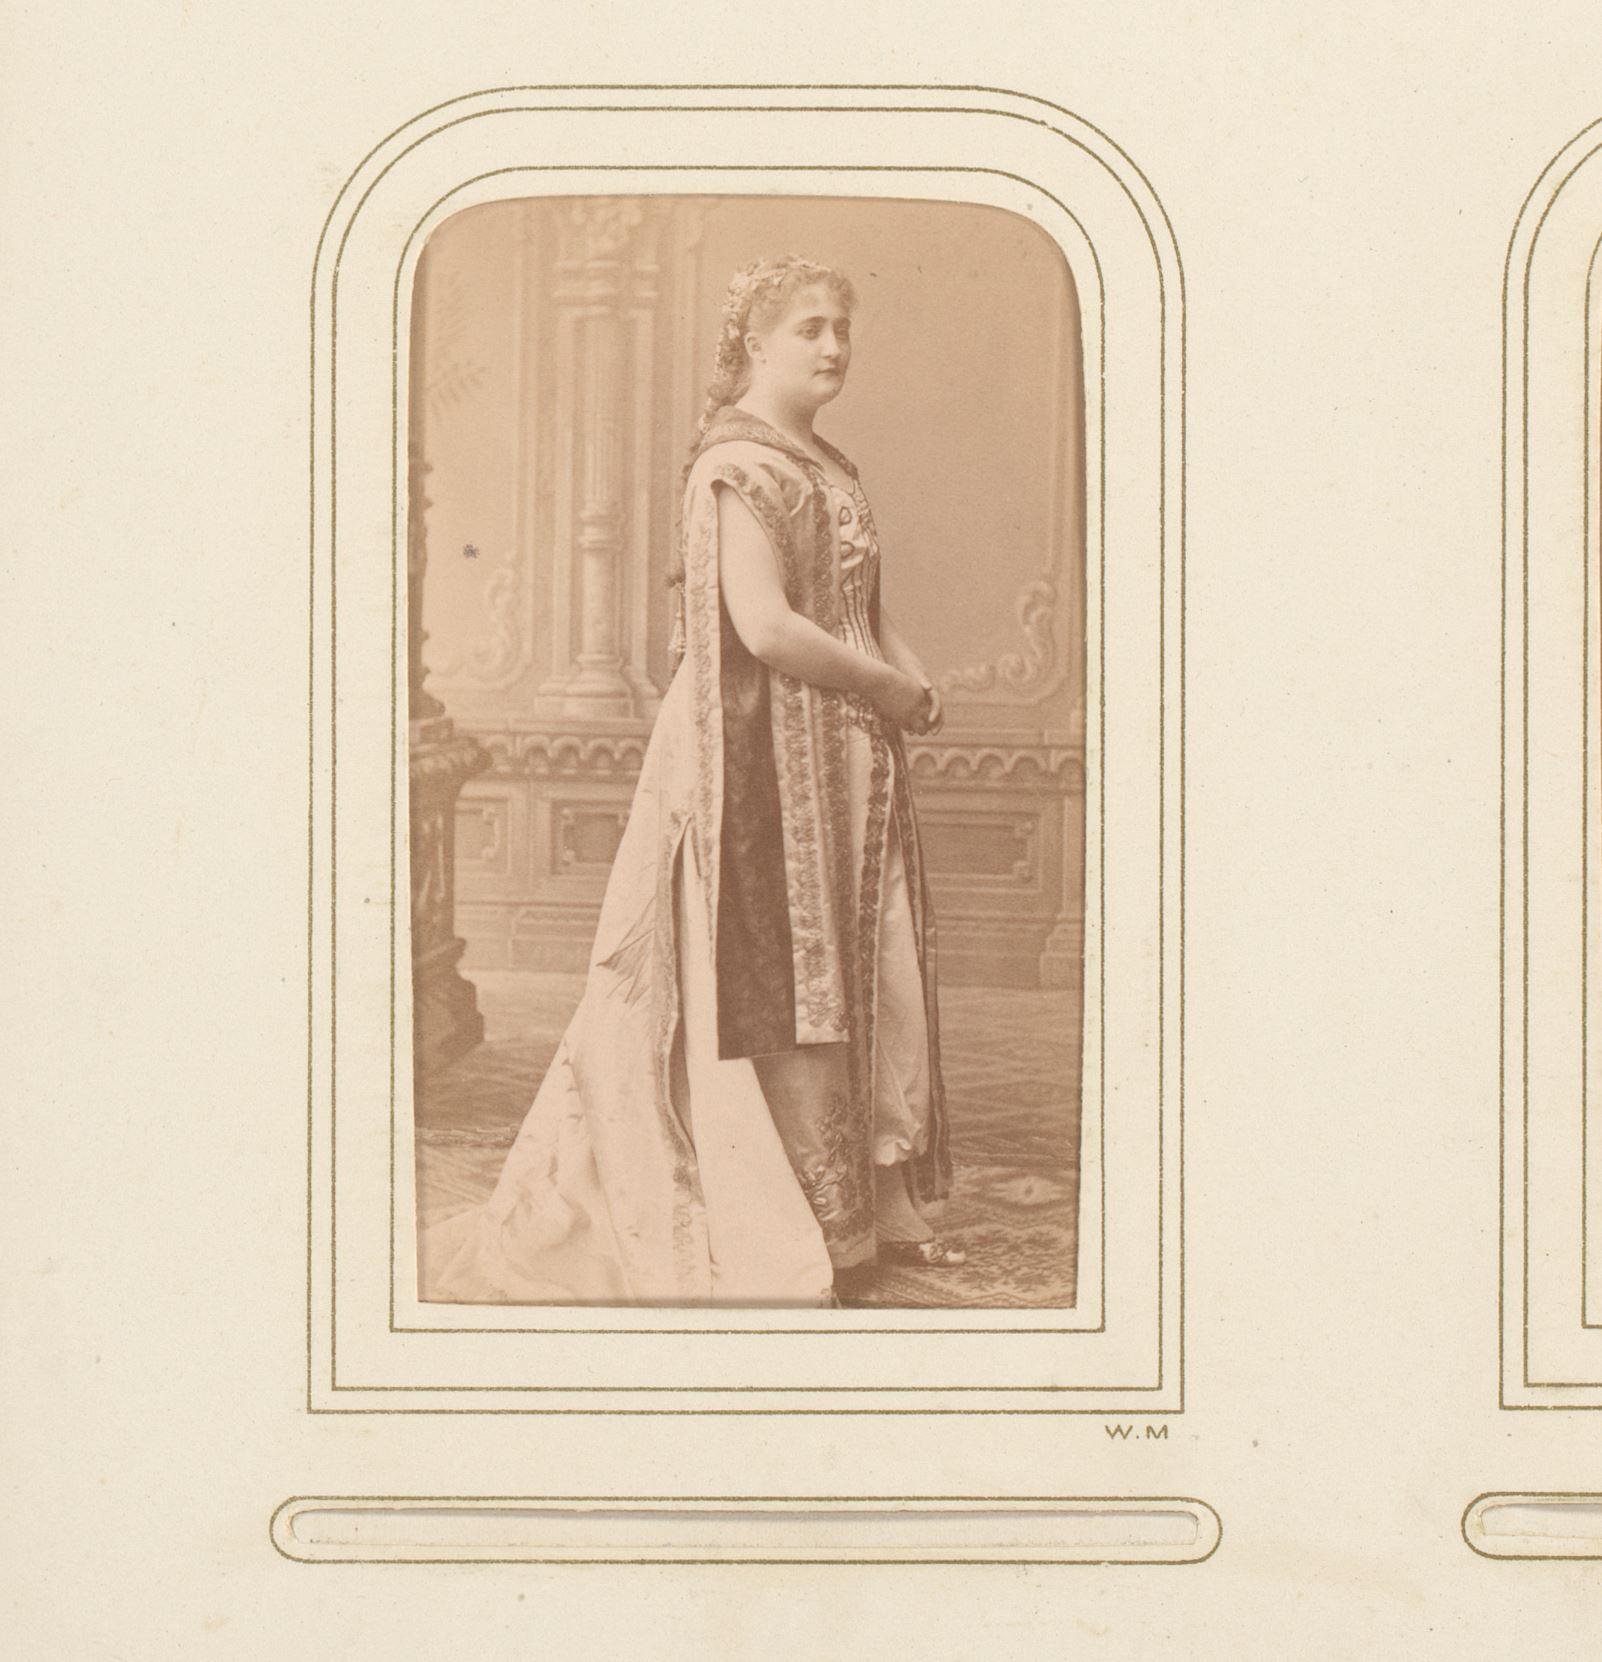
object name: carte de visite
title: Portret van Anna Maria Strandberg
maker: waldemar dahllöf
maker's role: fotograaf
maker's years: 1844-1935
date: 1870-1885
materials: cardboard, photographic support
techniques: albumen print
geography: stockholm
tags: historical persons - bb - woman, portrait of actor, actress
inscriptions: annotation: ‘Anna Strandberg/ - Bergman/ b. 1852’, inscription: ‘WALDEMAR DAHLLÖF & Cos/ ATELIER/ 52 a Clara Bergsgatan 52 a./ STOCKHOLM/ Plåten förvaras för efterbeställning.’